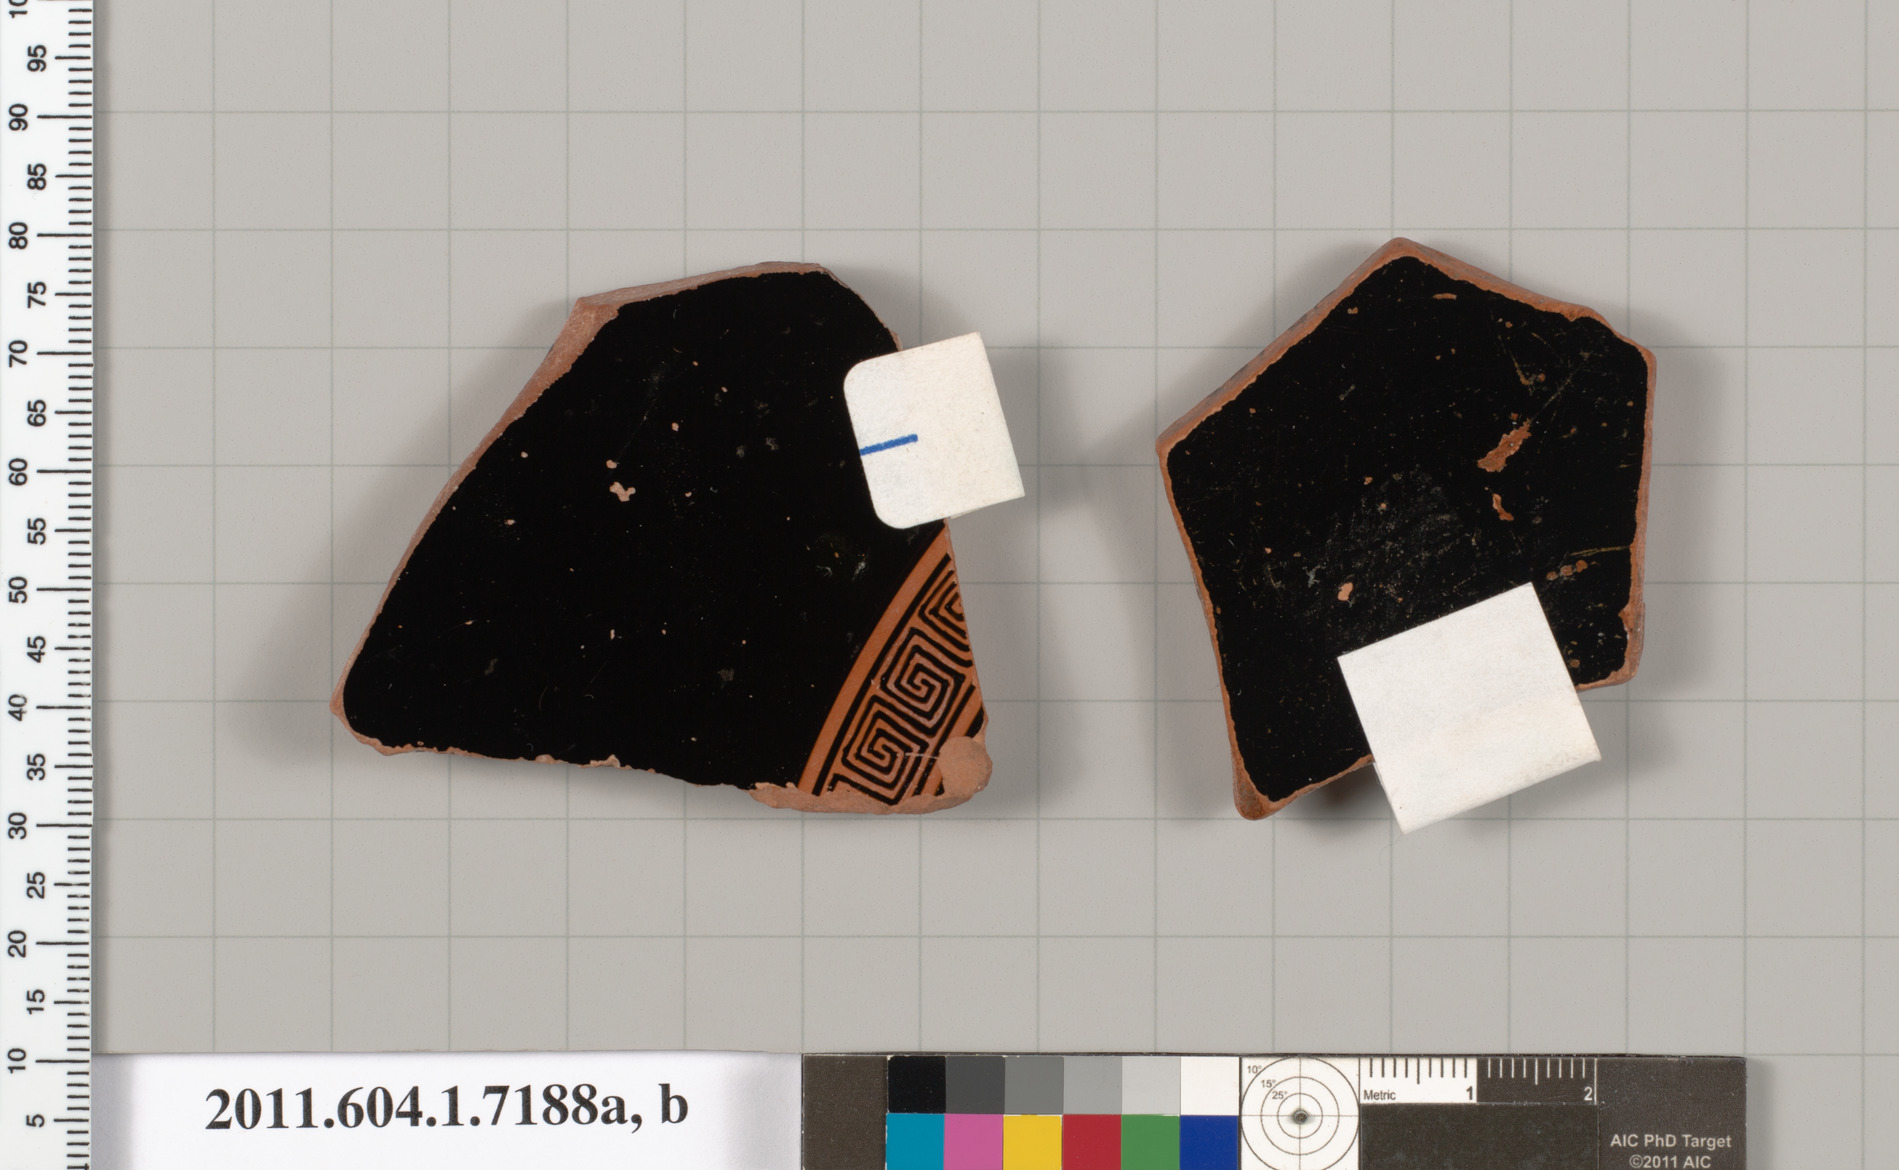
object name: kylix fragment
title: Terracotta fragments of a kylix (drinking cup)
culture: greek, attic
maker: makron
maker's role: artist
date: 500-480 BCE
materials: terracotta